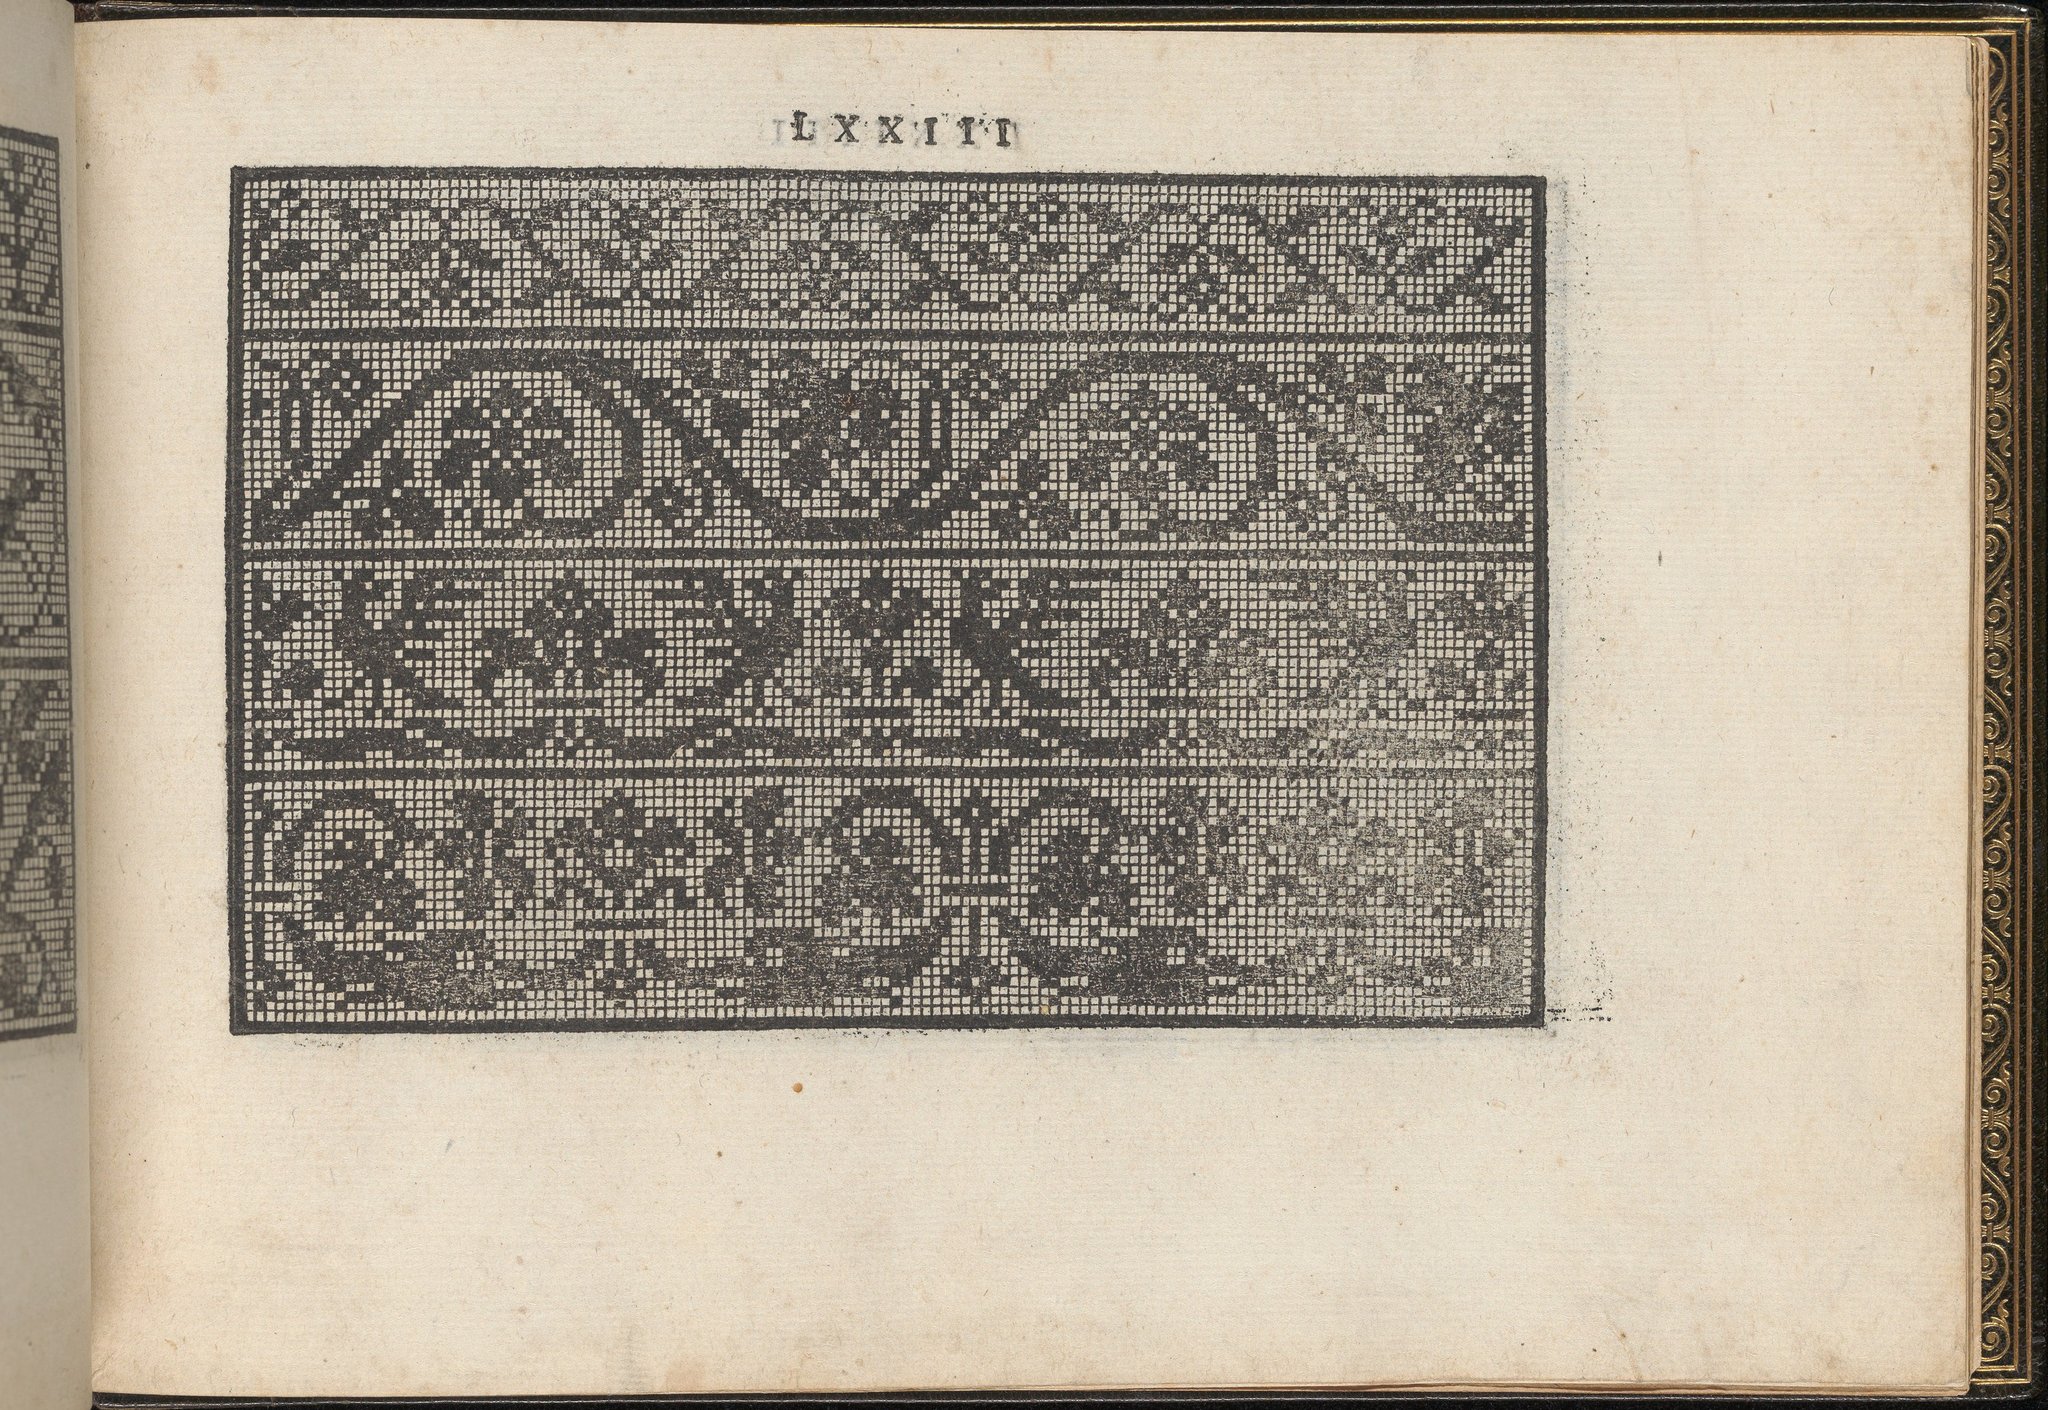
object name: book print ornament architecture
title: La Vera Perfettione del Disegno di varie sorti di recami, page 37 (recto)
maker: giovanni ostaus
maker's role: publisher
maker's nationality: italian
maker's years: 1507-1607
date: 1567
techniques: woodcut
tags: birds,flowers